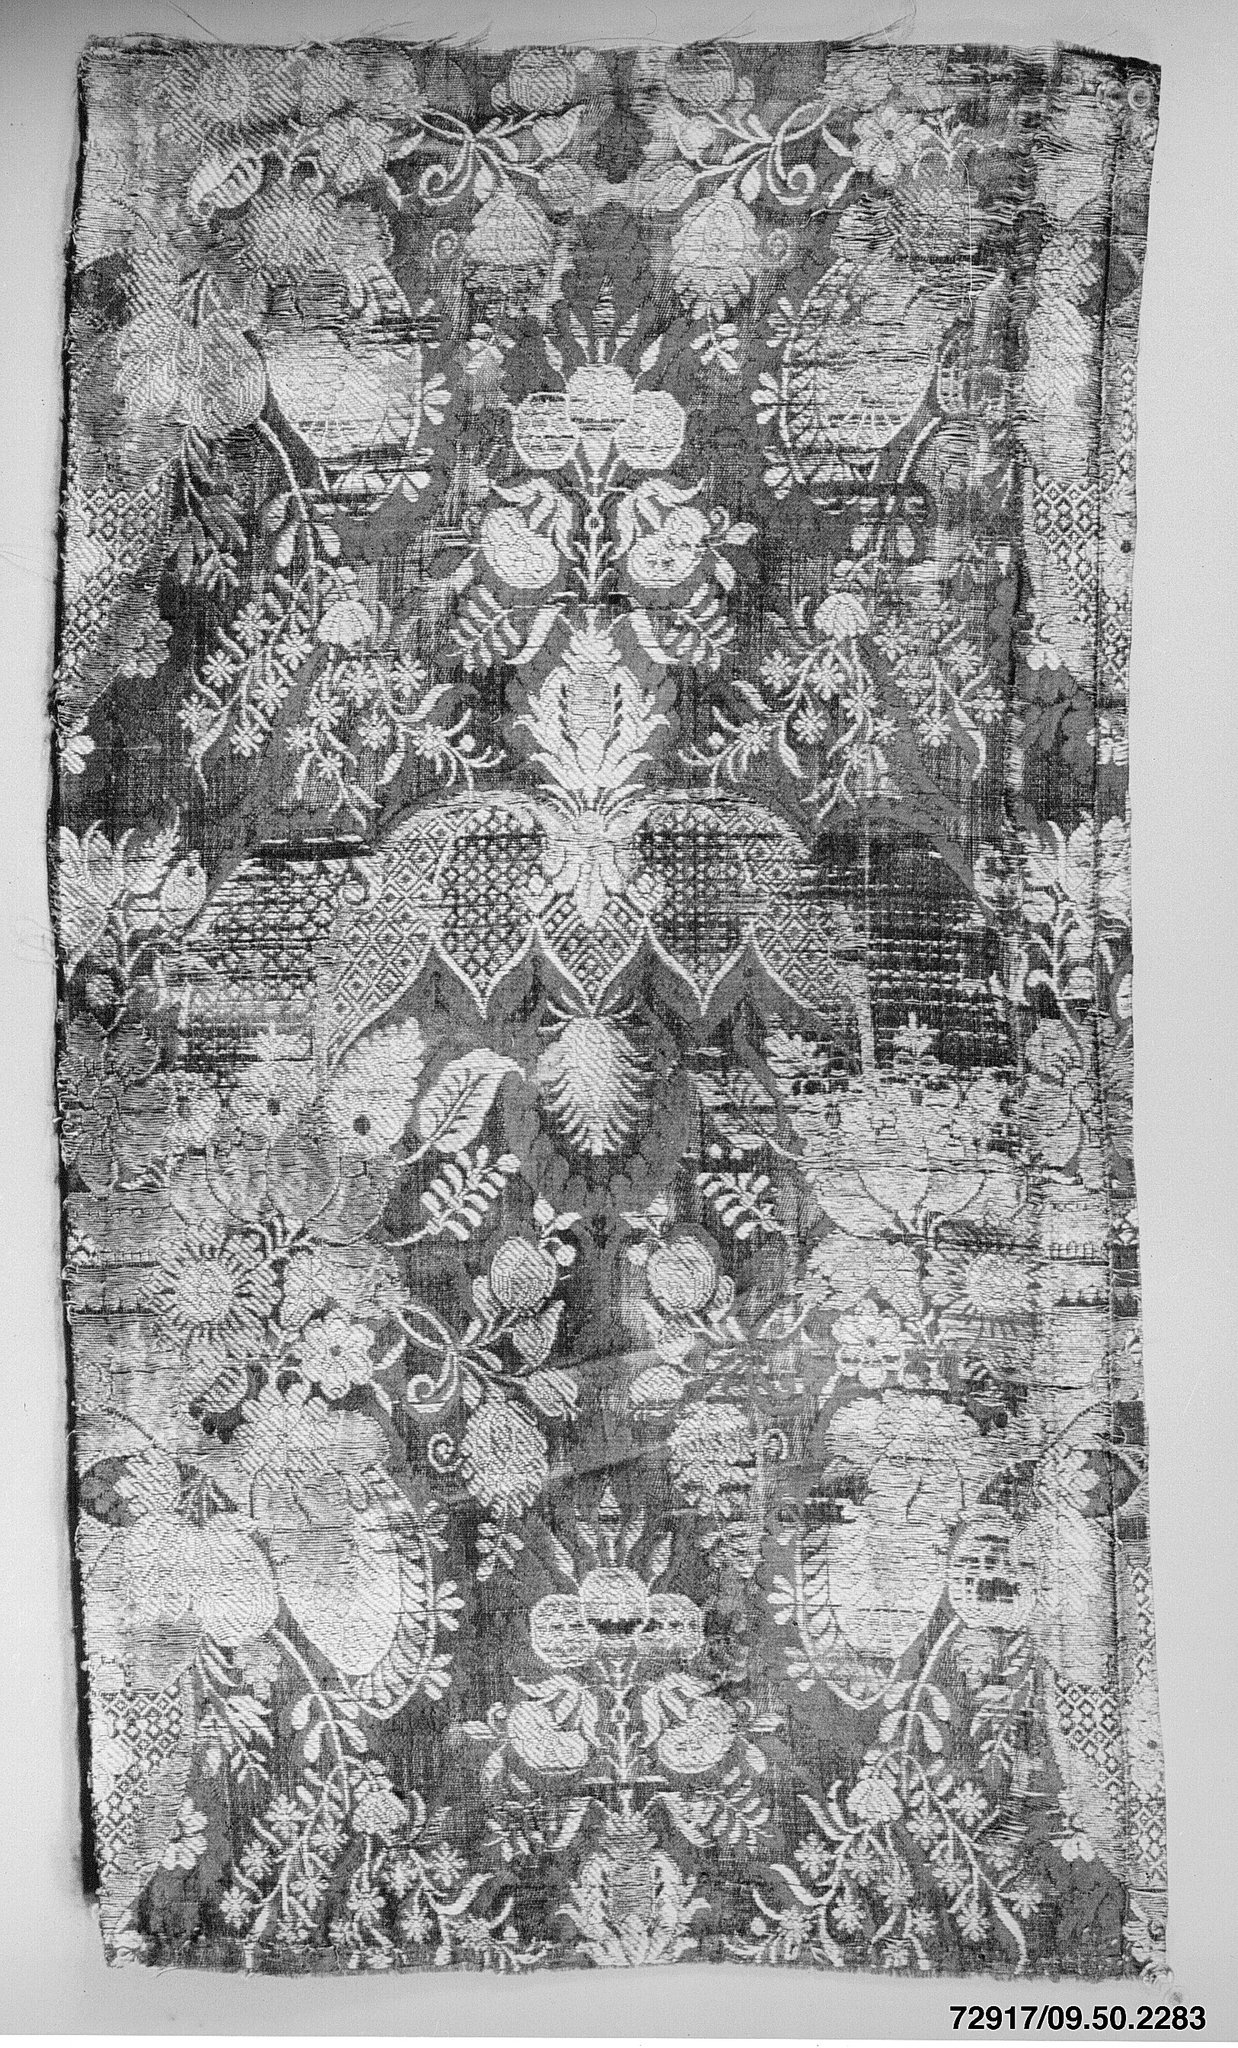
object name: piece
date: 1725-1730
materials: metal thread, silk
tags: flowers,leaves